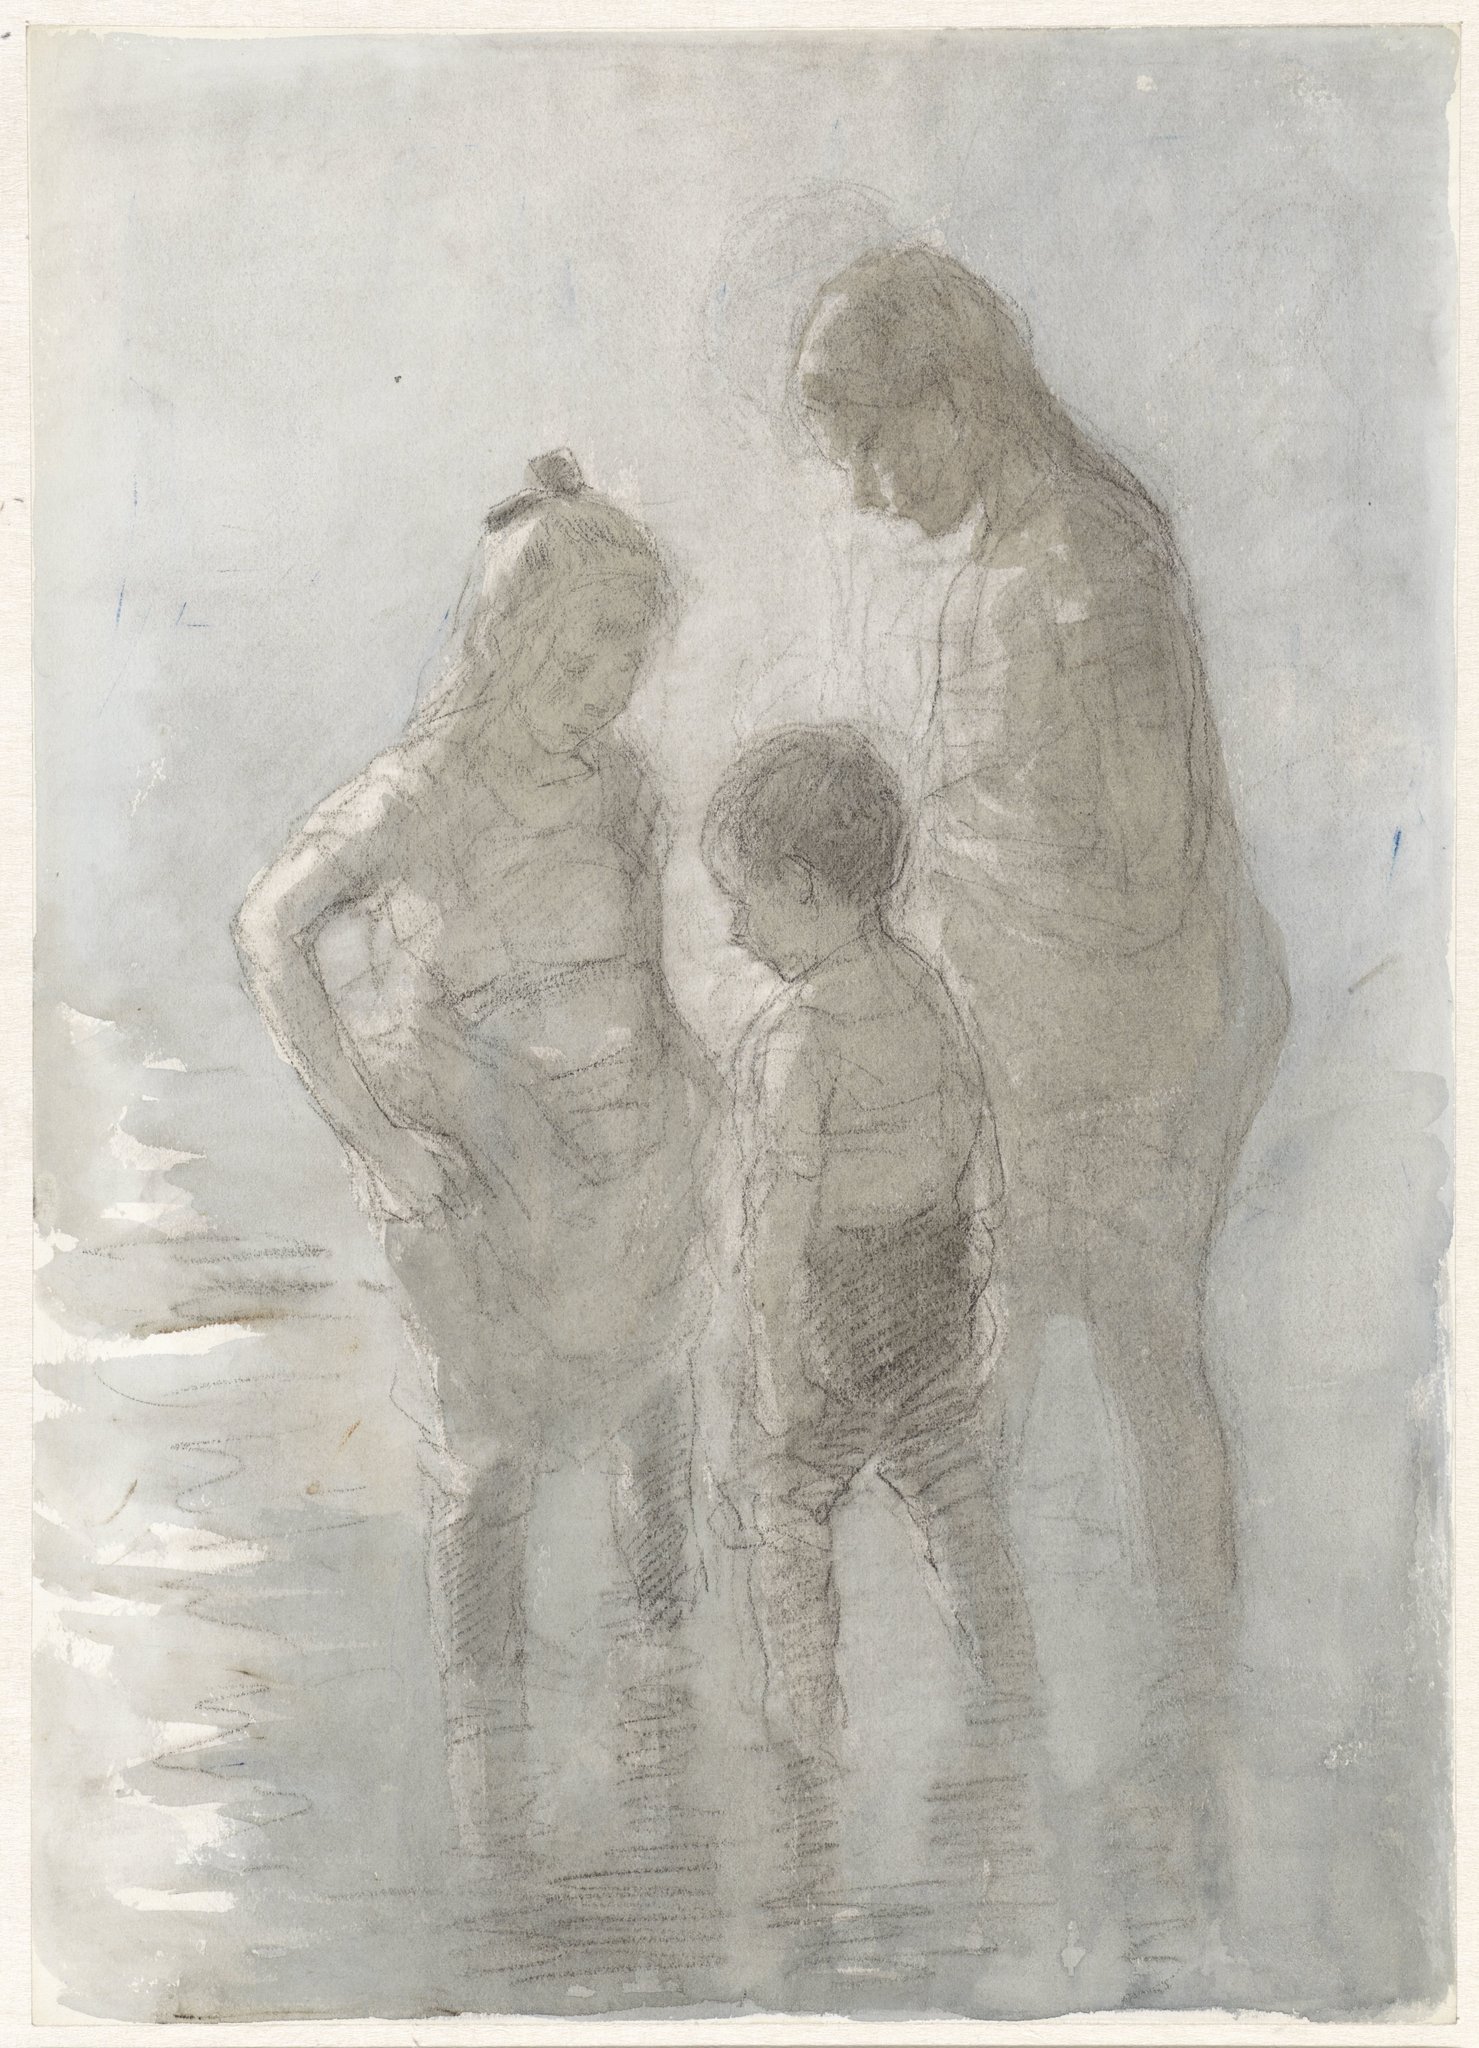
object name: drawing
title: Drie pootjebadende kinderen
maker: johan antonie de jonge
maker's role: draughtsman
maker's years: 1864-1927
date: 1874-1927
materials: chalk, paper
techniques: brush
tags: in or beside the water (on the beach)